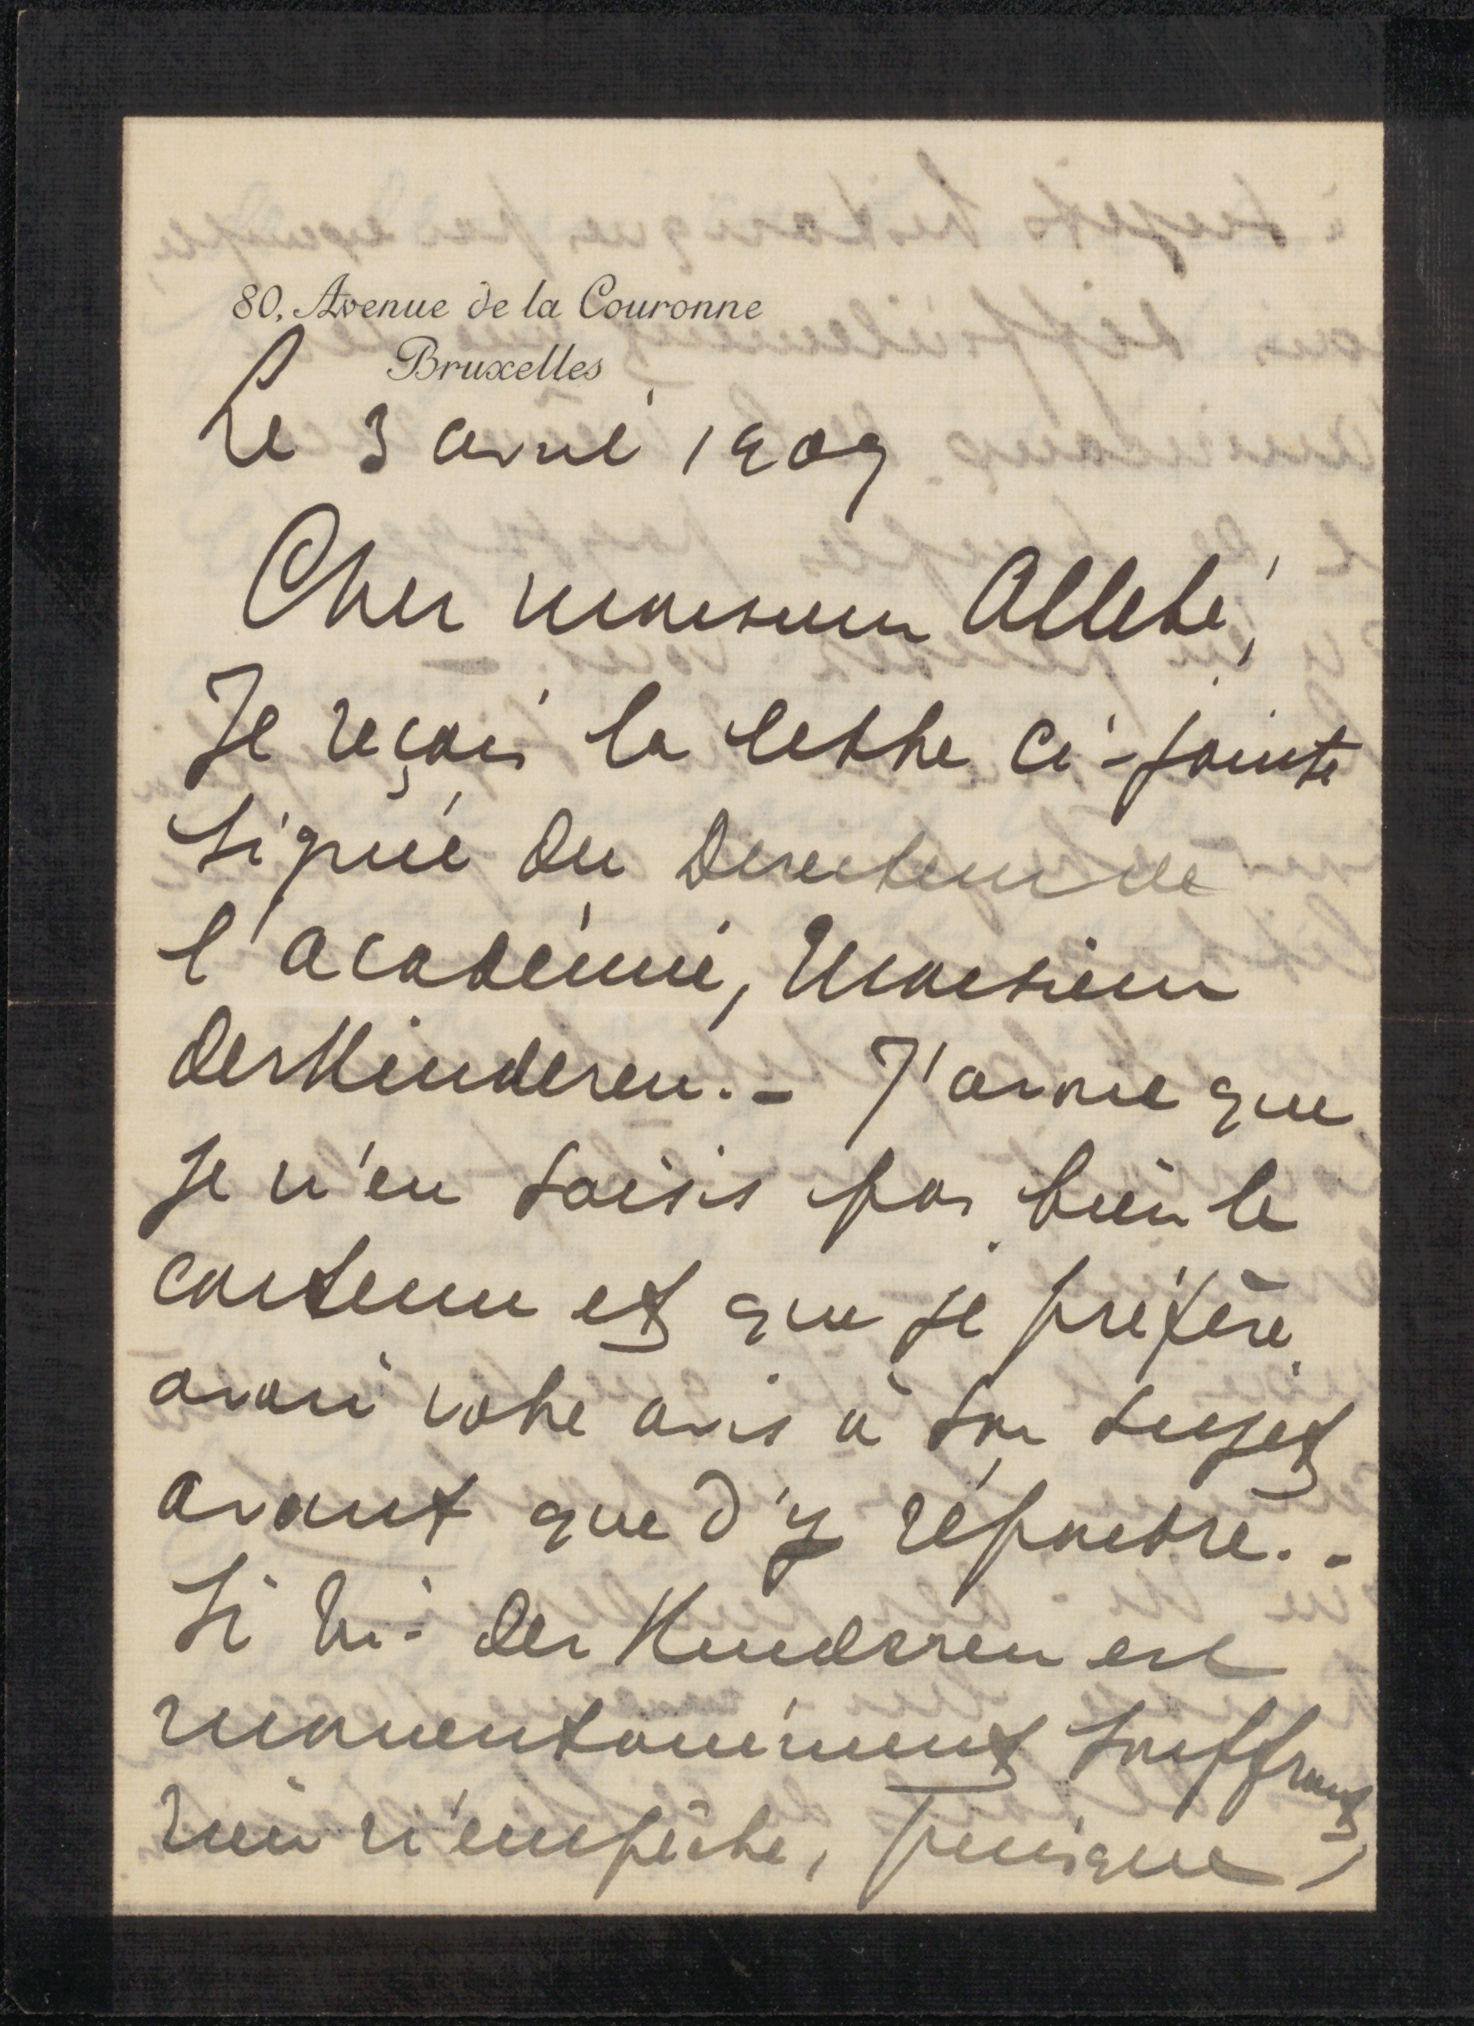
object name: letter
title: Brief aan August Allebé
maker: e. de haas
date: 1909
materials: ink, paper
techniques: pen, printing, writing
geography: brussels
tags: august allebé, painter, draughtsman, johannes hubertus leonardus de haas, den bosch, amsterdam, print maker, antoon derkinderen, the graphic arts, painting (including book-illumination, miniature-painting), exhibition ~ art, historical persons (portraits and scenes from the life)